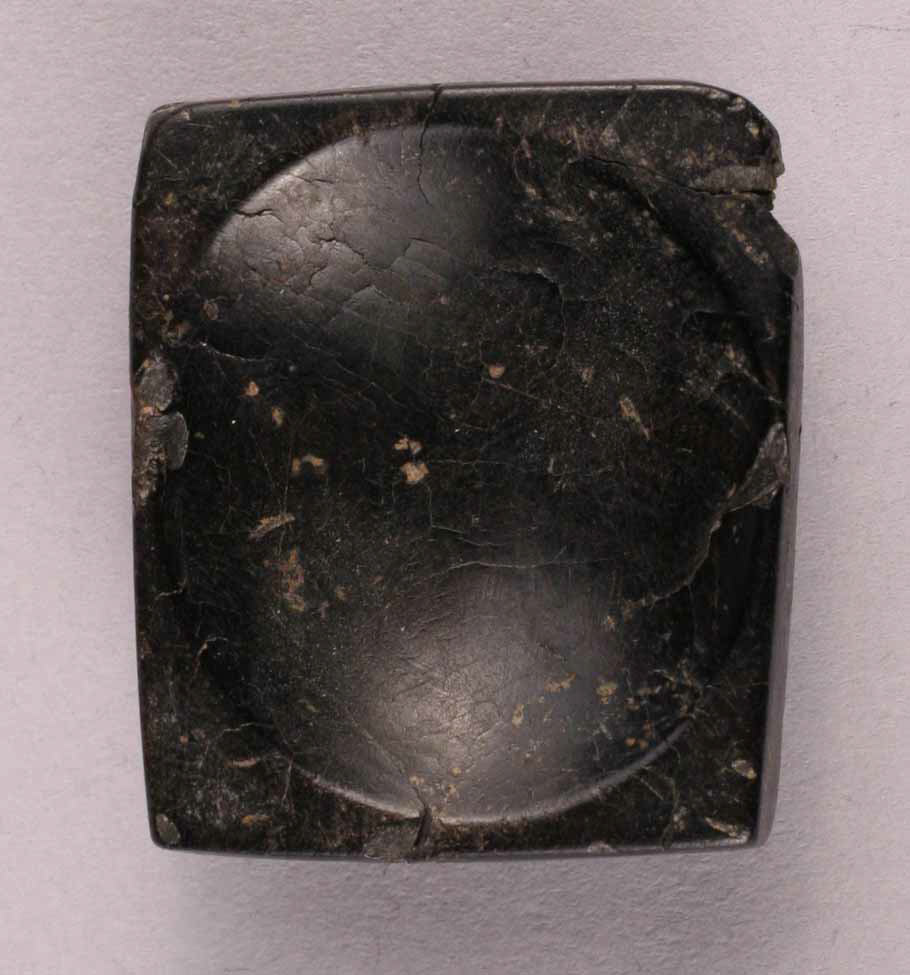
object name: palette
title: Possibly a Palette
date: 701-1200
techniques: cutting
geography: iran